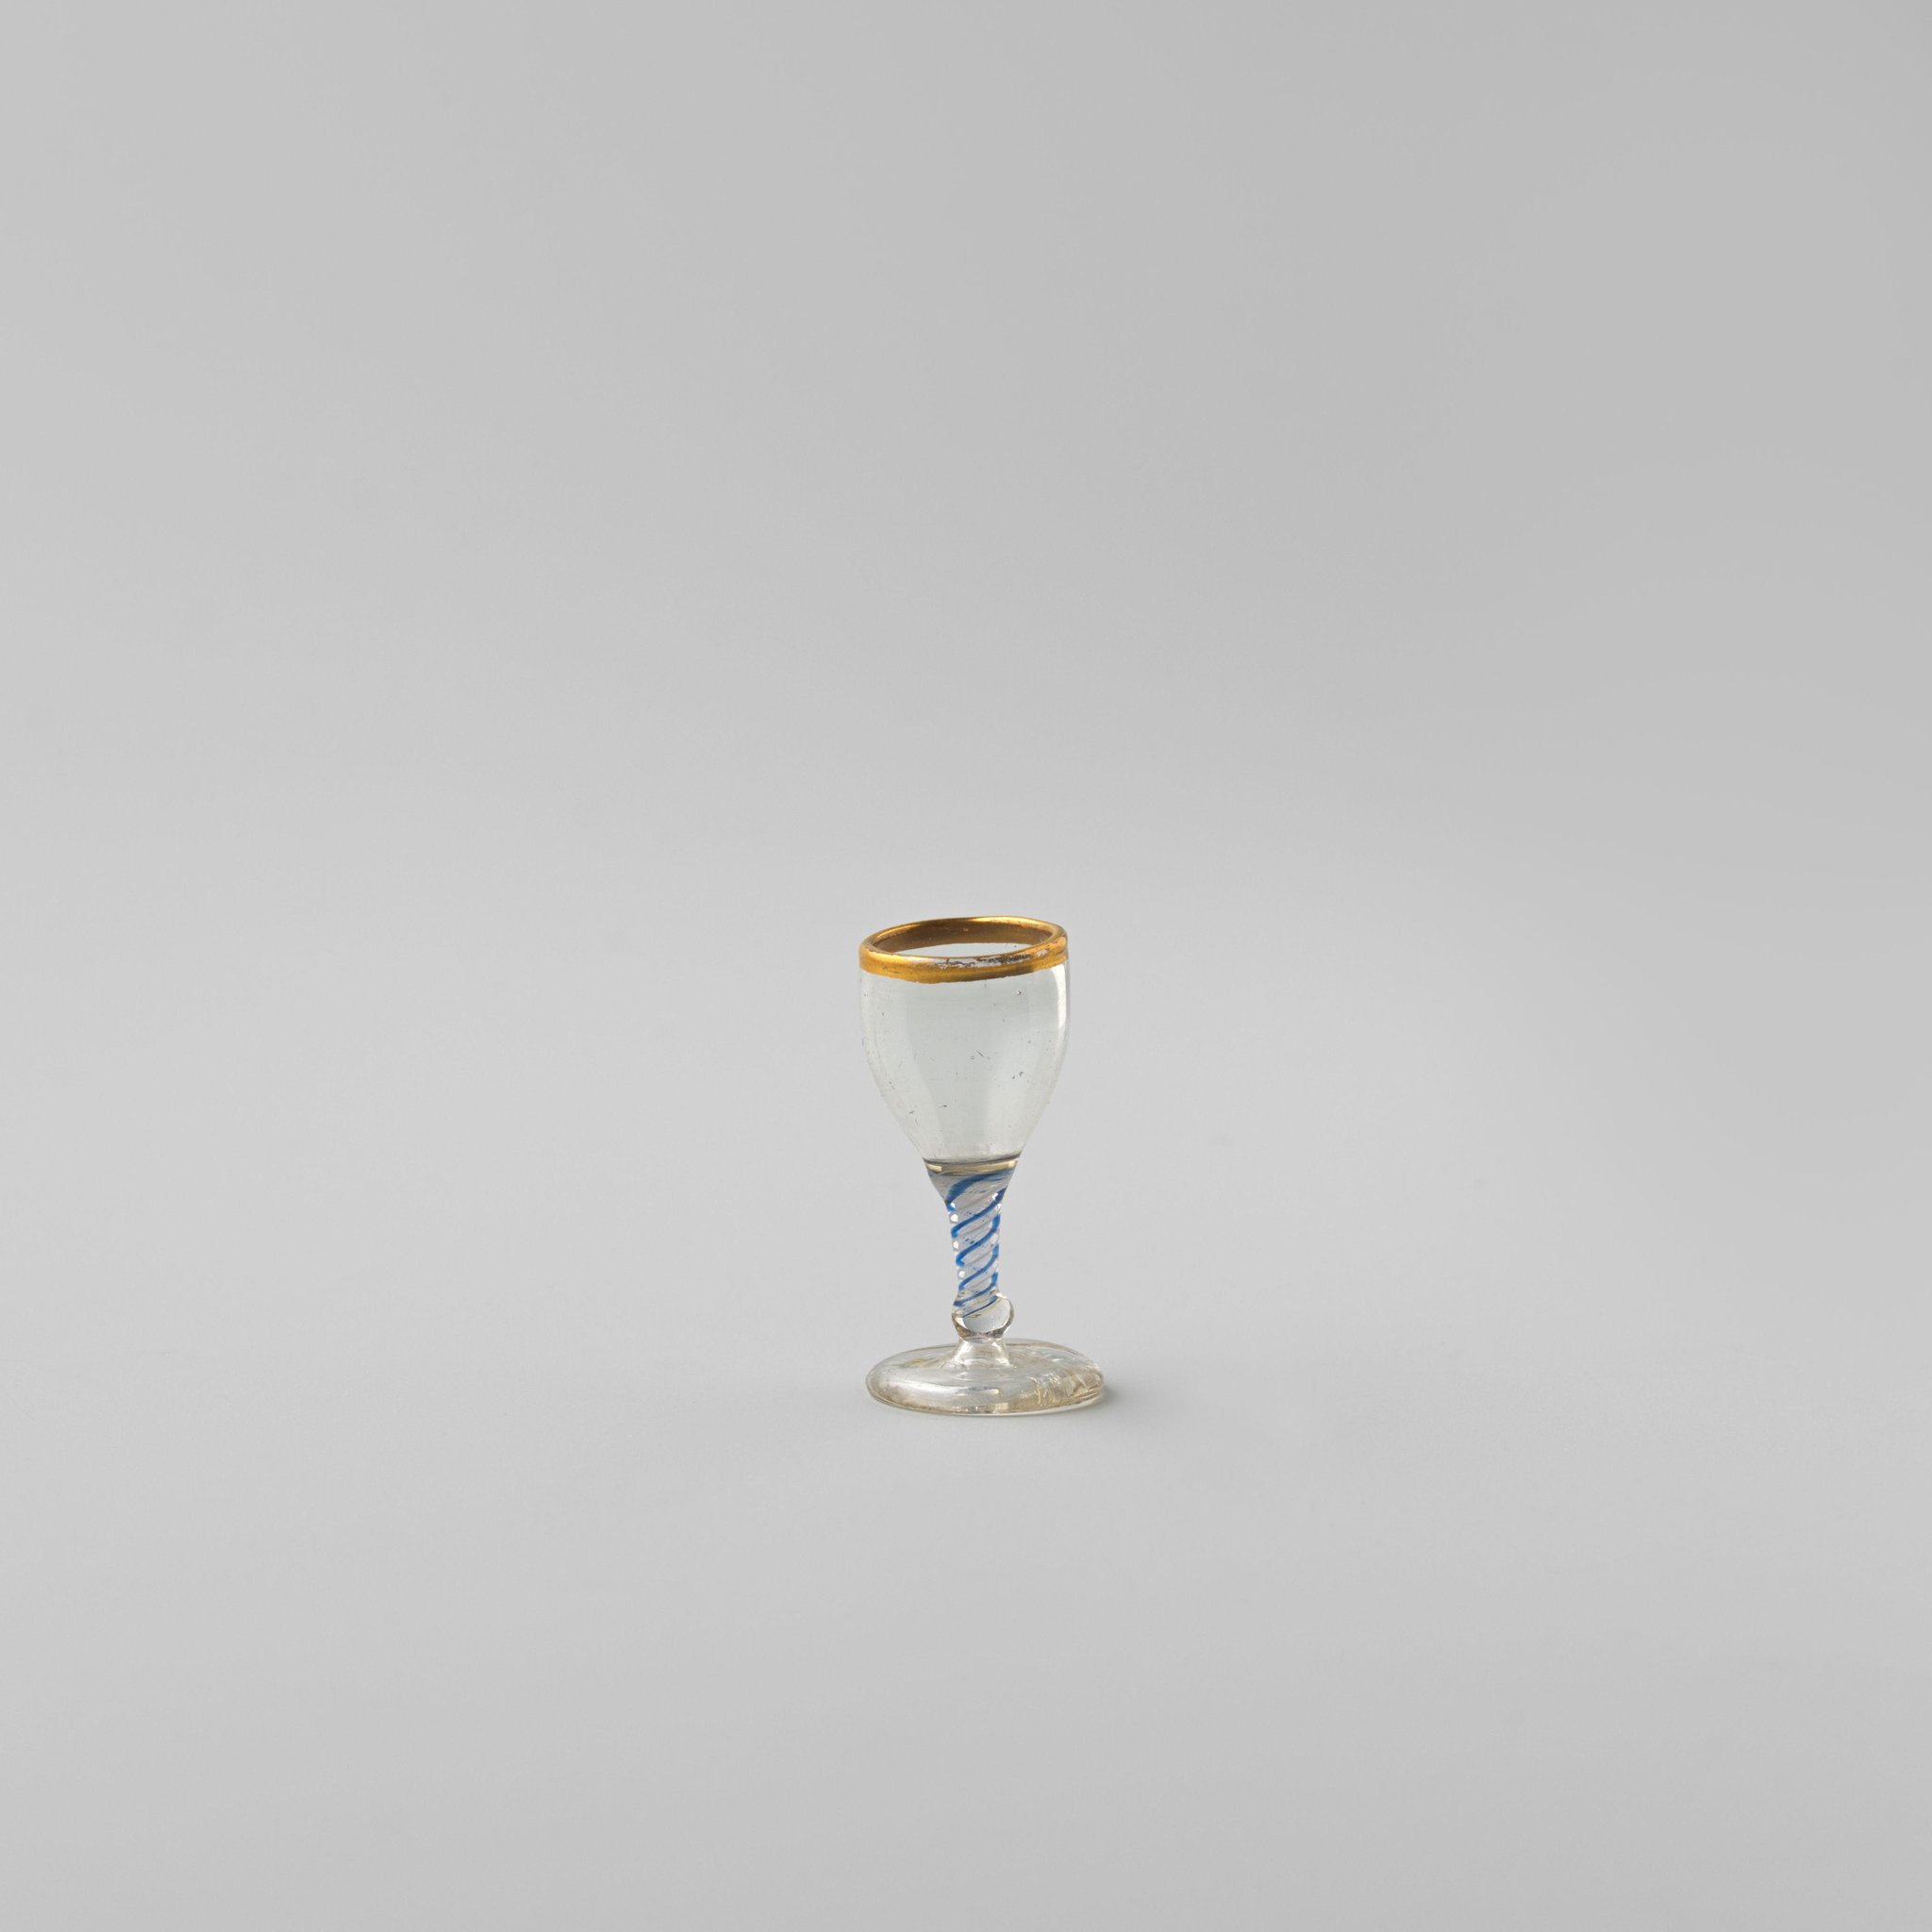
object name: miniature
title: Slingerglas, met stam met witte en blauwe spiralen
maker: Anonymous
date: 1800-1849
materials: glass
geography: bristol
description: Slingerglas van helder, kleurloos glas, eivormige kelk met vergulde mondrand, op stam met opaak witte en blauwe spiralen, met nodus, overgaand in brede platte voet met verdikte rand. Behorend tot een set van zes stuks.